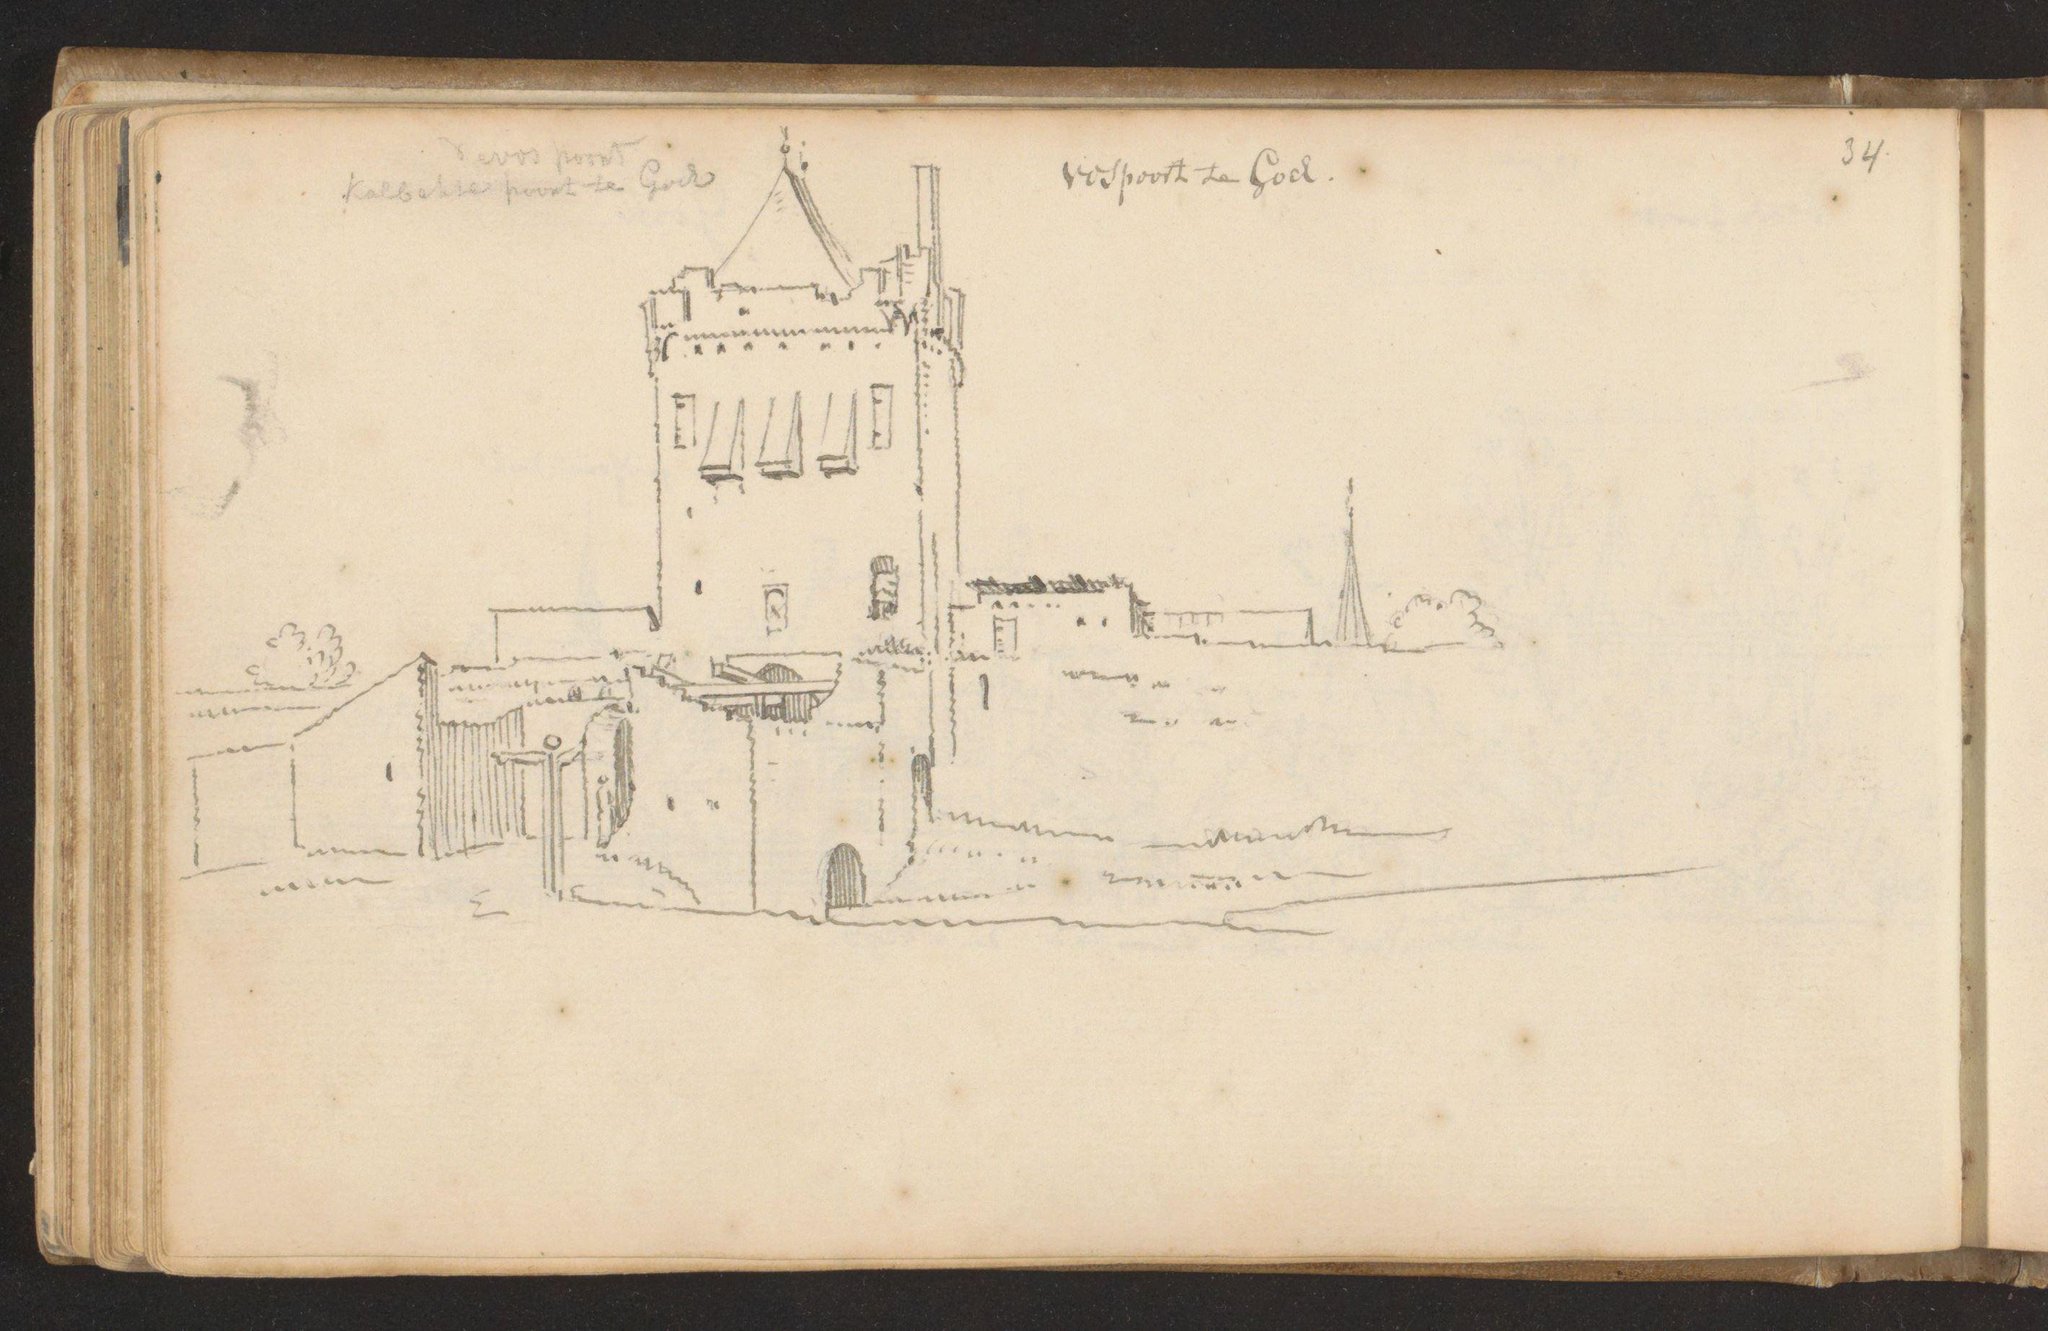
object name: sketchbook leaf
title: Vospoort te Goch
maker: abraham de haen (ii)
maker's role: draughtsman, print maker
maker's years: 1707-1748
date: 1731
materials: ink, paper, pencil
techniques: pen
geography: goch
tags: city-gate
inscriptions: annotation: ‘Vos poort/ Kalbekse poort te Goch/ Vospoort te Goch’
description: Pagina 34 (genummerd) uit een schetsboek met 69 bladen.